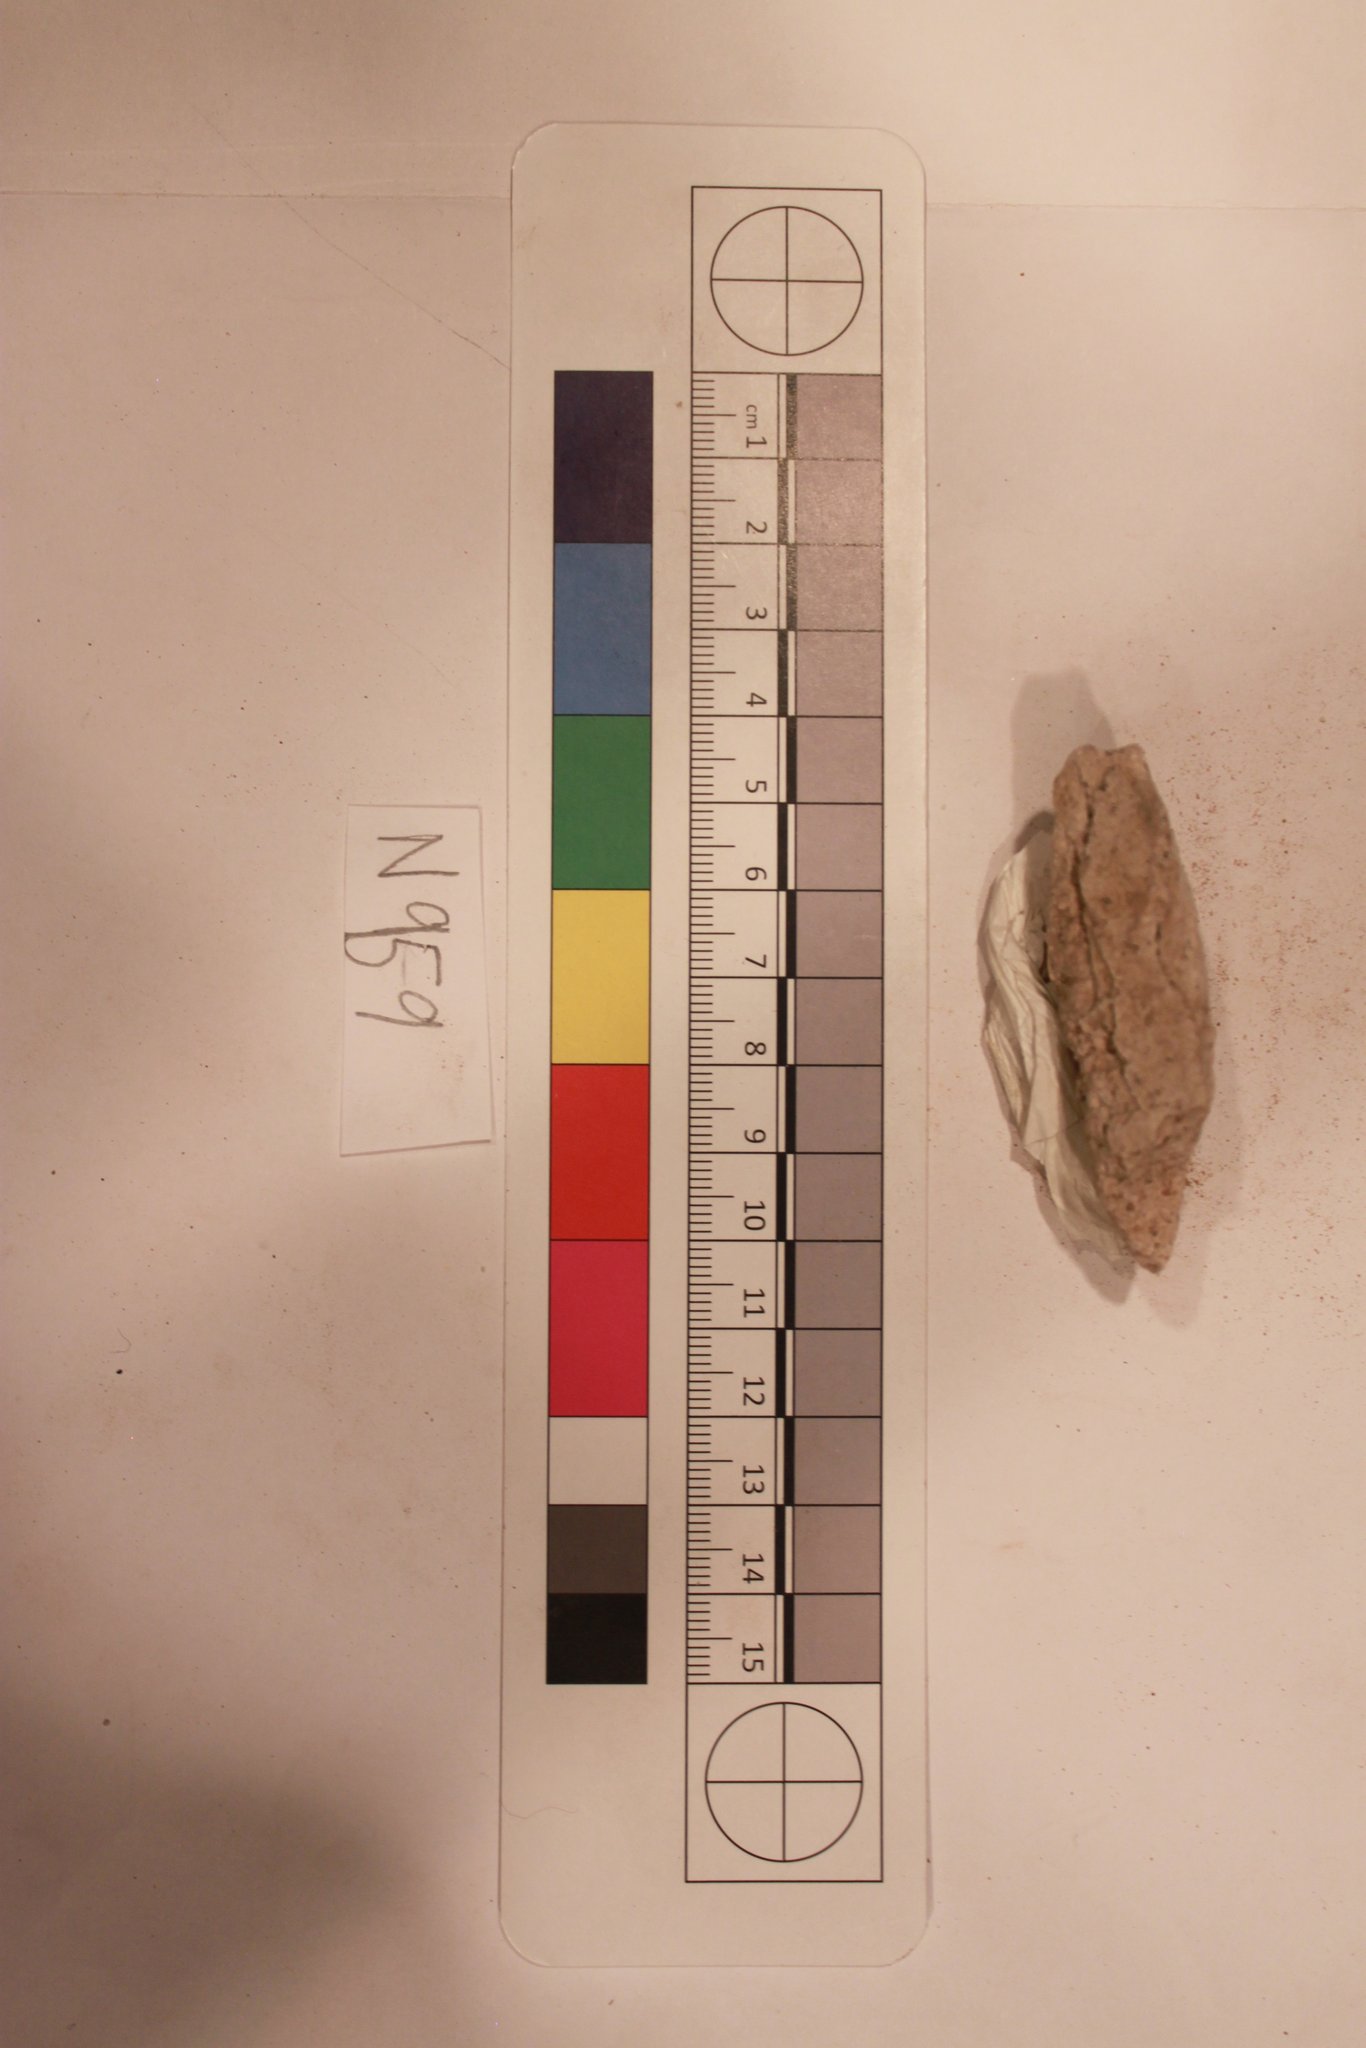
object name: fragment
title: Stucco Fragment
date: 701-1200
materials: plaster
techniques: carving, painting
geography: iran